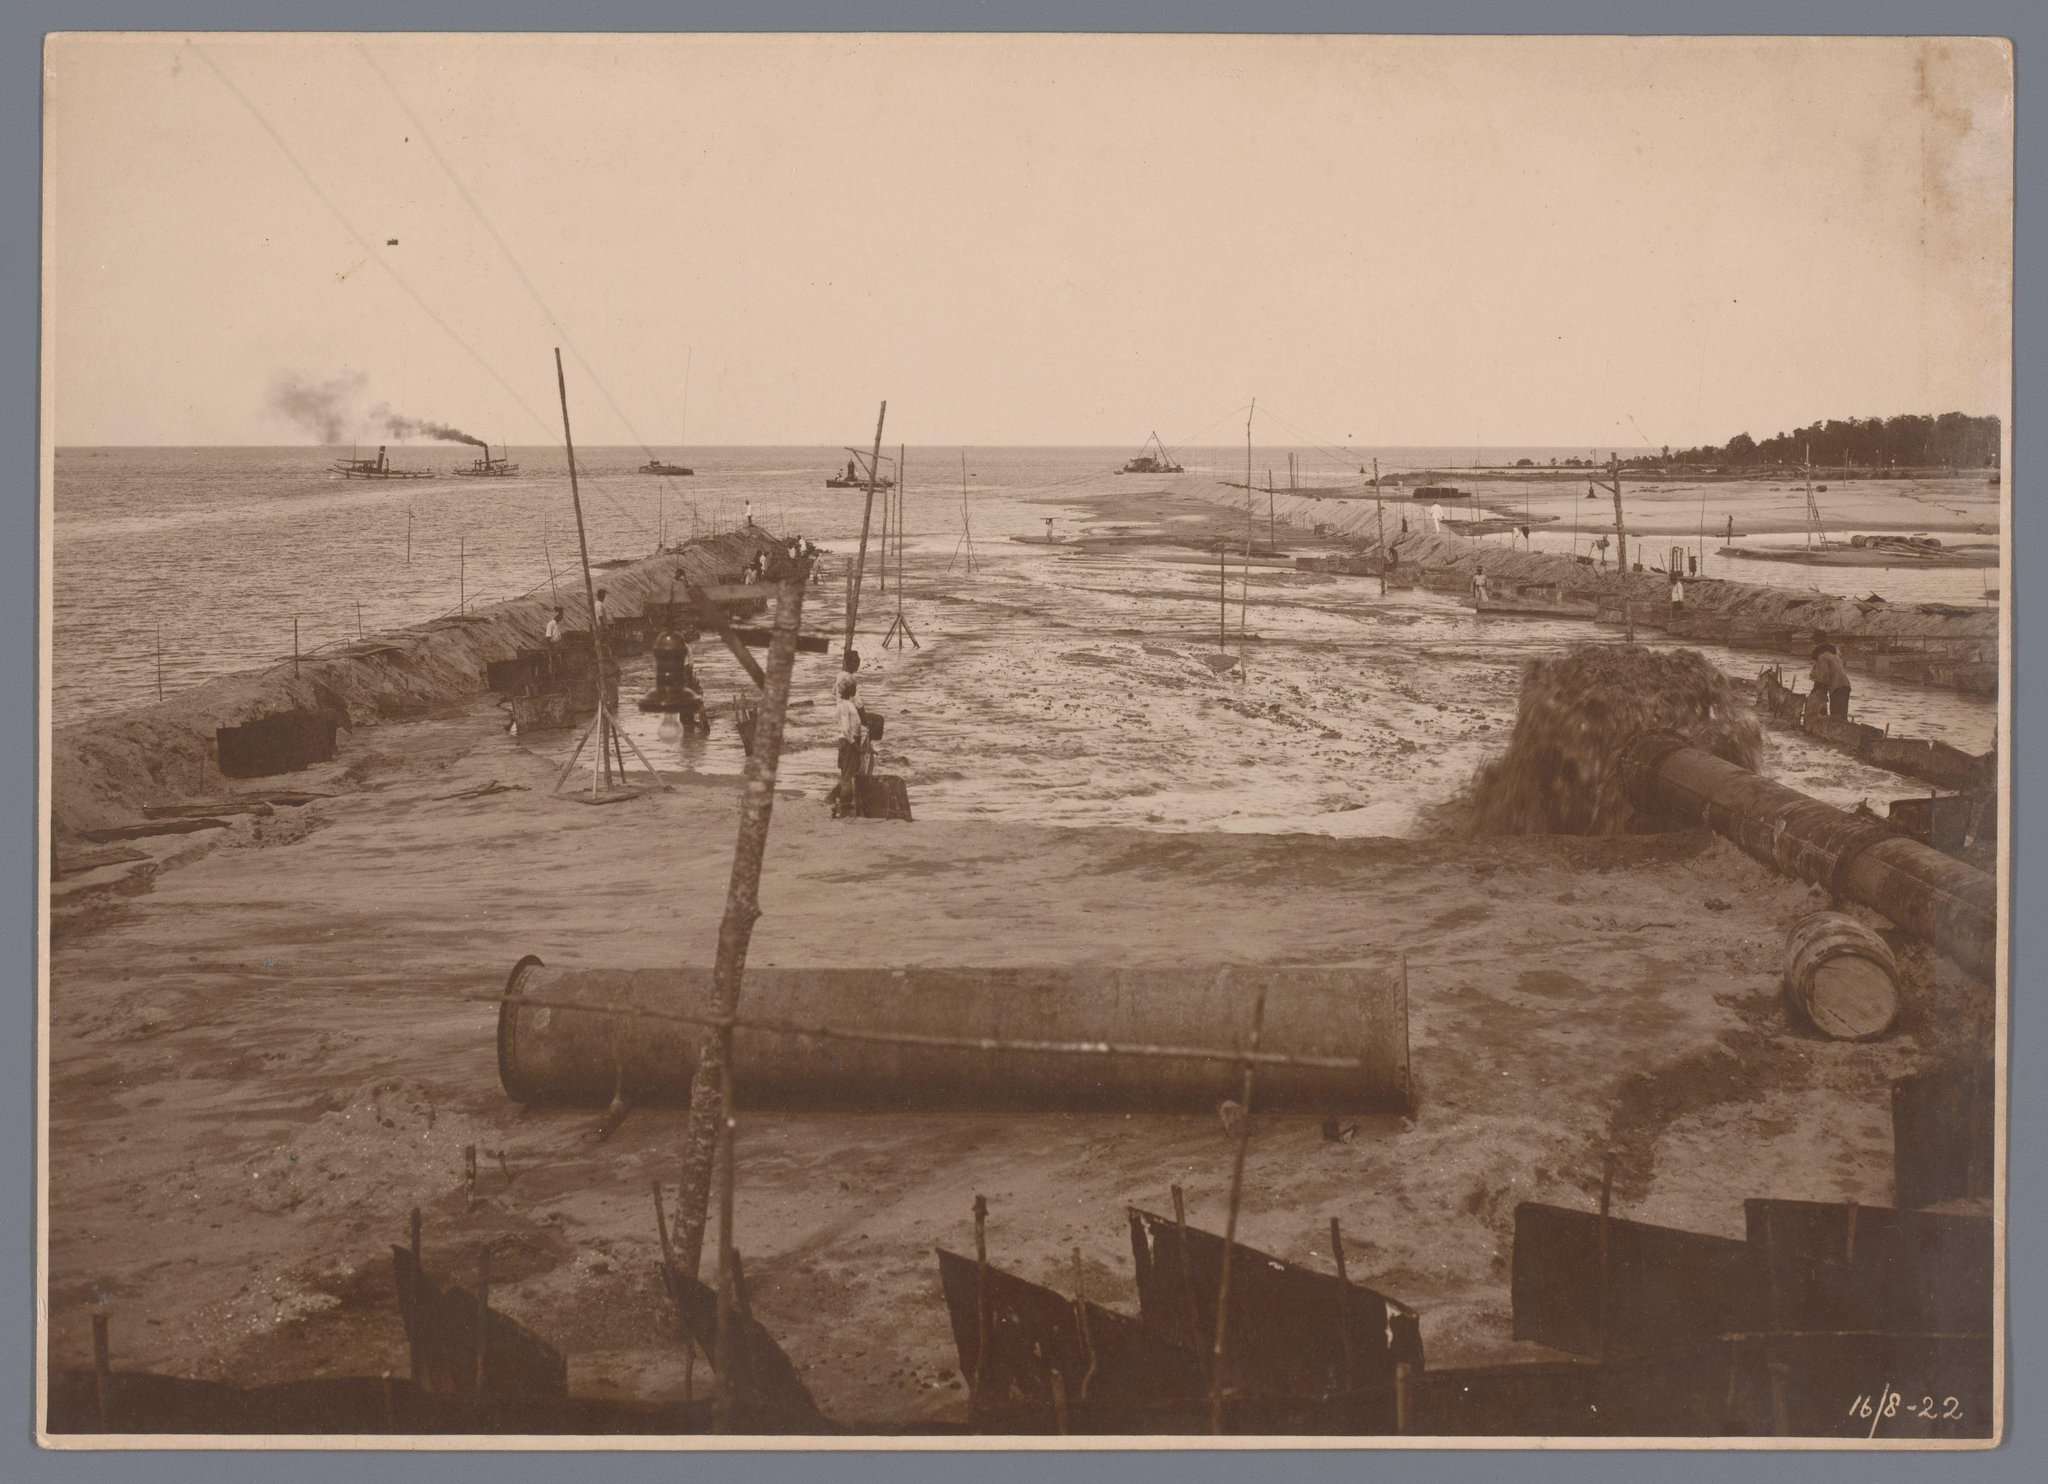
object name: photograph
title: Oceaanhaven Belawan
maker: Anonymous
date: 1922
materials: photographic support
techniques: gelatin silver print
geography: belawan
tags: harbour, building-site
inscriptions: date: ‘16/8-22’, annotation: ‘No. 186 / Het wegzuigen en wederopspuiten voor 1e 100 m. der zandbelasting’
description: Het wegzuigen en weer opspuiten van zand. Genummerd: 186. Onderdeel van de groep van losse foto's over de aanleg van de haven Belawan aan de kust voor Medan, Sumatra 1921-1922.